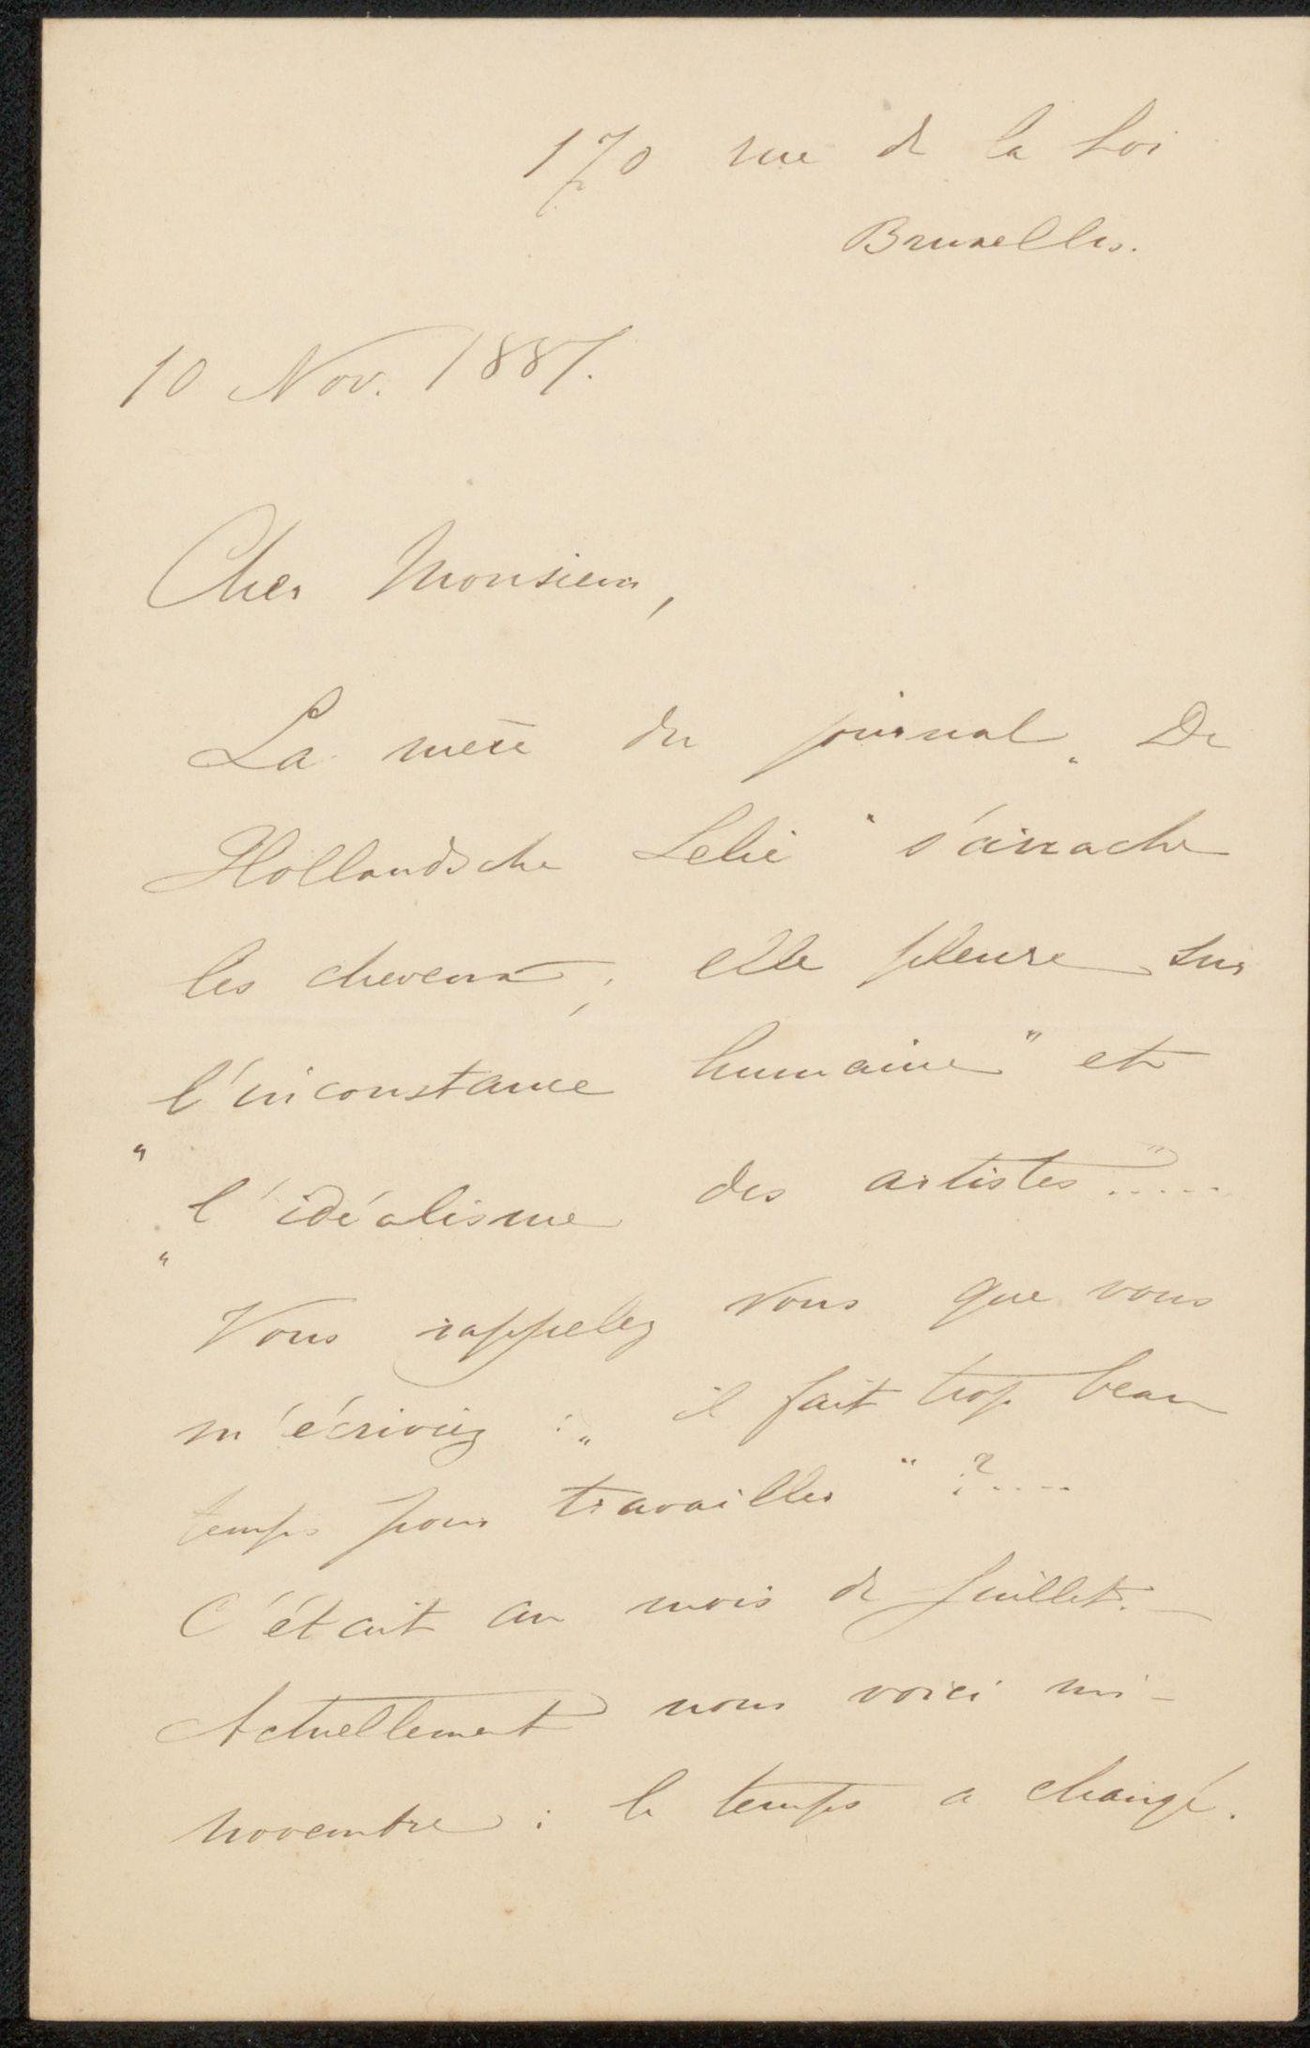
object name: letter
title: Brief aan Philip Zilcken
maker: catharina alberdingk thijm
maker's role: schrijver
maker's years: 1848-1908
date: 1887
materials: ink, paper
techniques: pen, writing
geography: brussels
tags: the hague, painter, philip zilcken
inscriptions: watermark, collector's mark: ‘RPK’